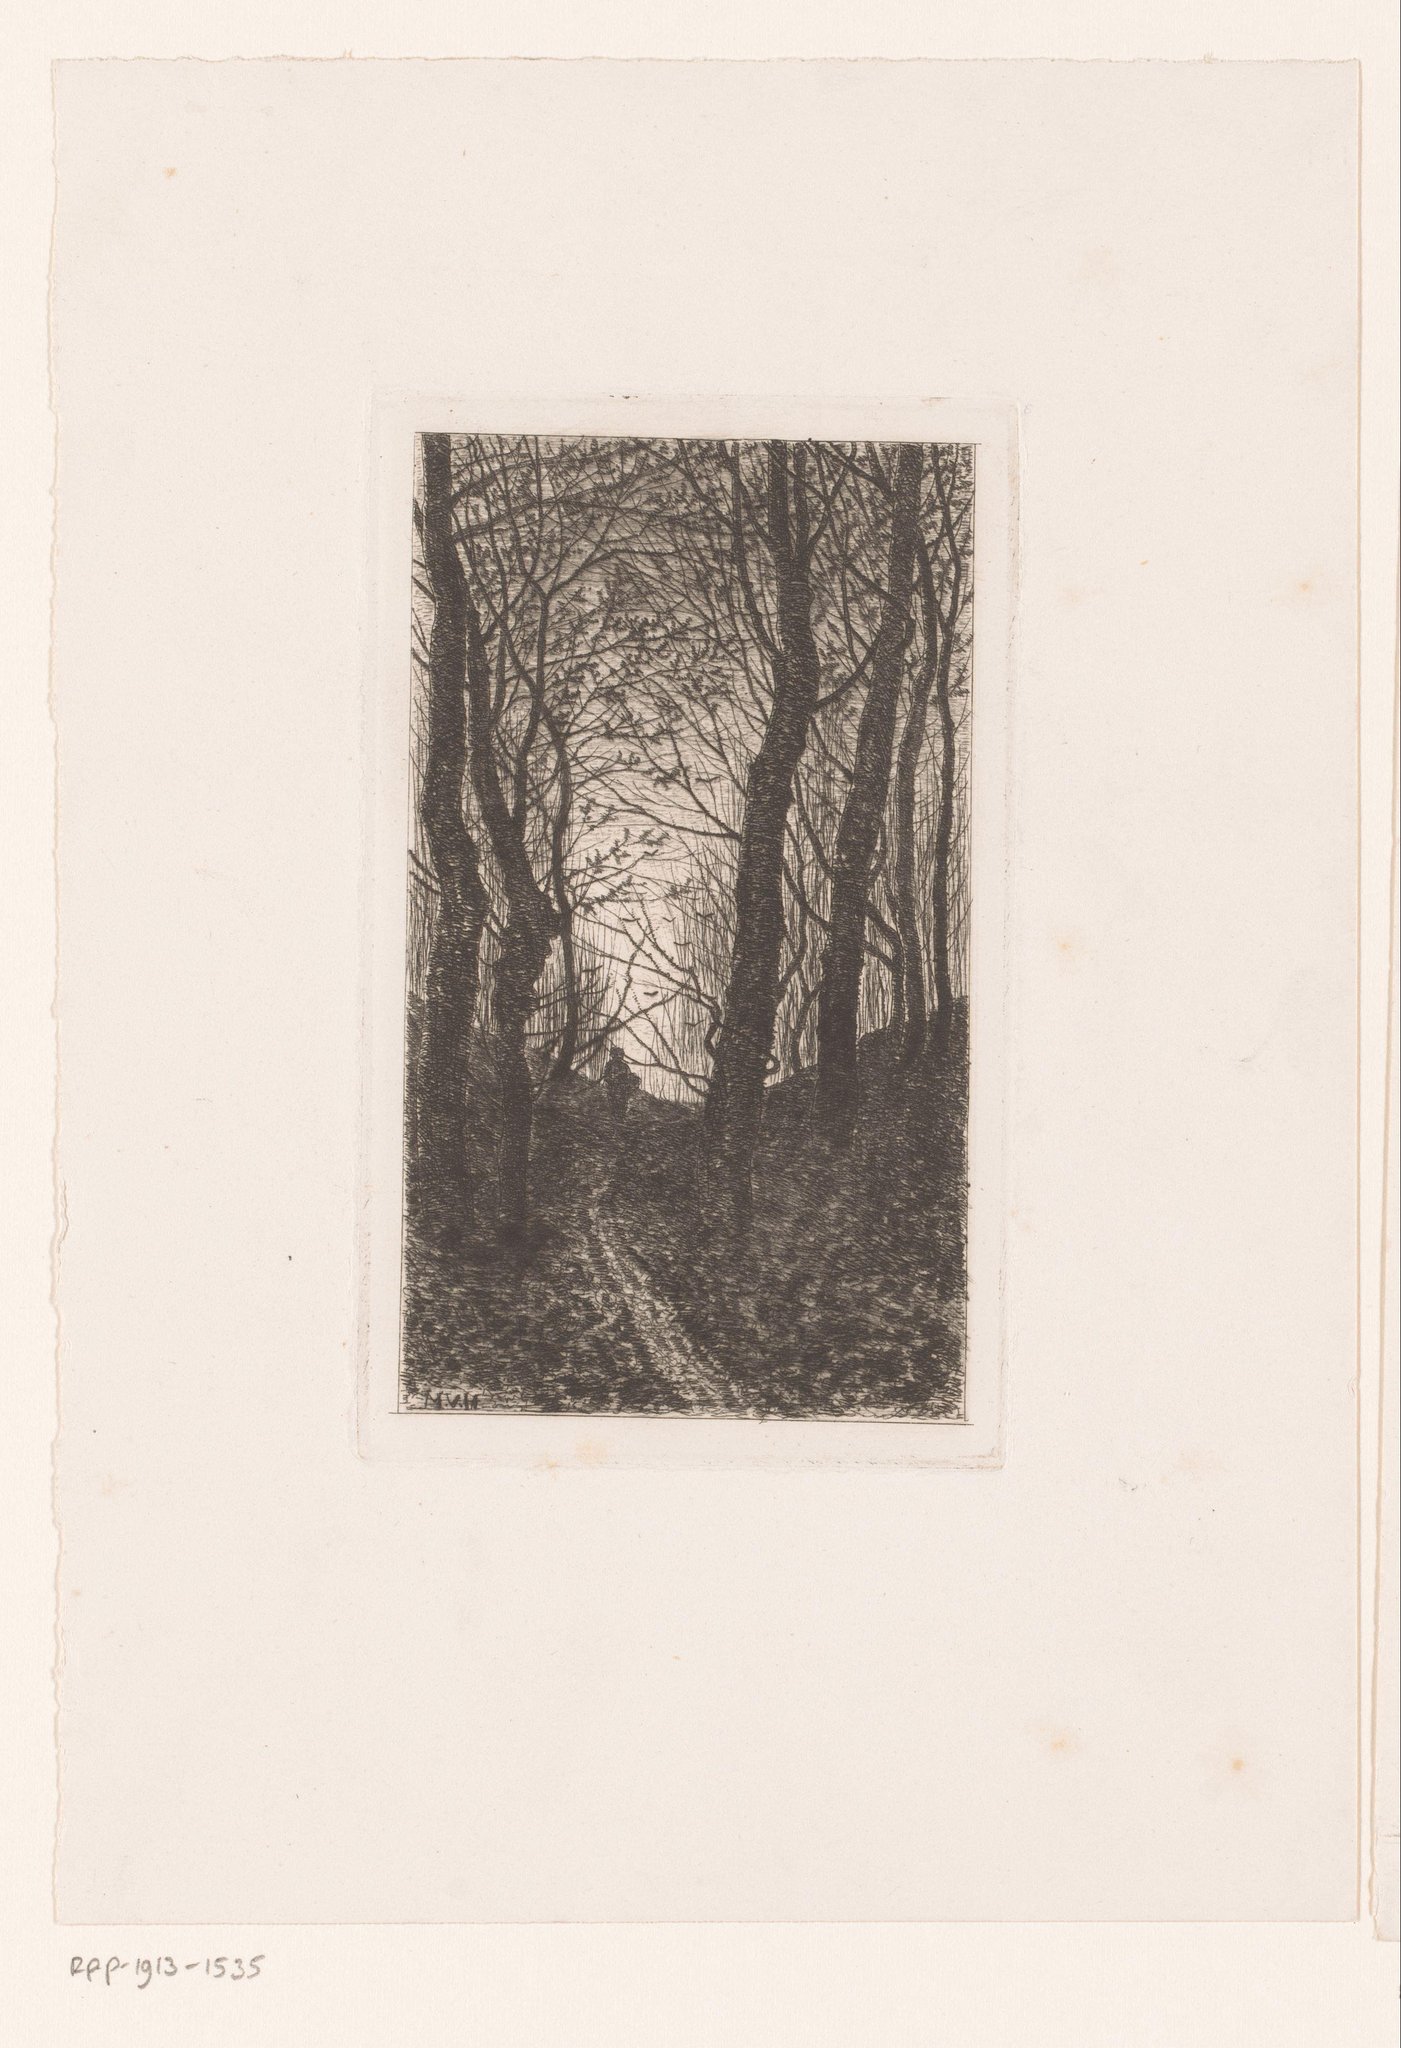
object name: print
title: Heuvelachtige bosweg met figuur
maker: h. van meerbeeck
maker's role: print maker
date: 1850-1913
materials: paper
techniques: etching, intaglio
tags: low hill country, forest path or lane (+ landscape with figures, staffage)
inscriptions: collector's mark: Lugt 2228